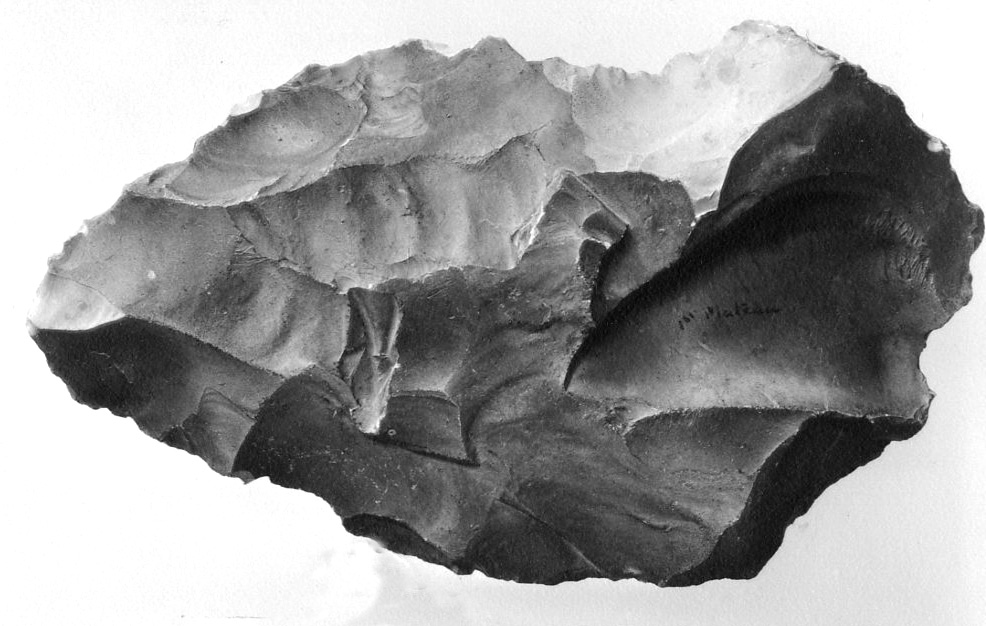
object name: tool, biface, hand ax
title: Biface, commonly referred to as a hand ax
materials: stone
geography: egypt